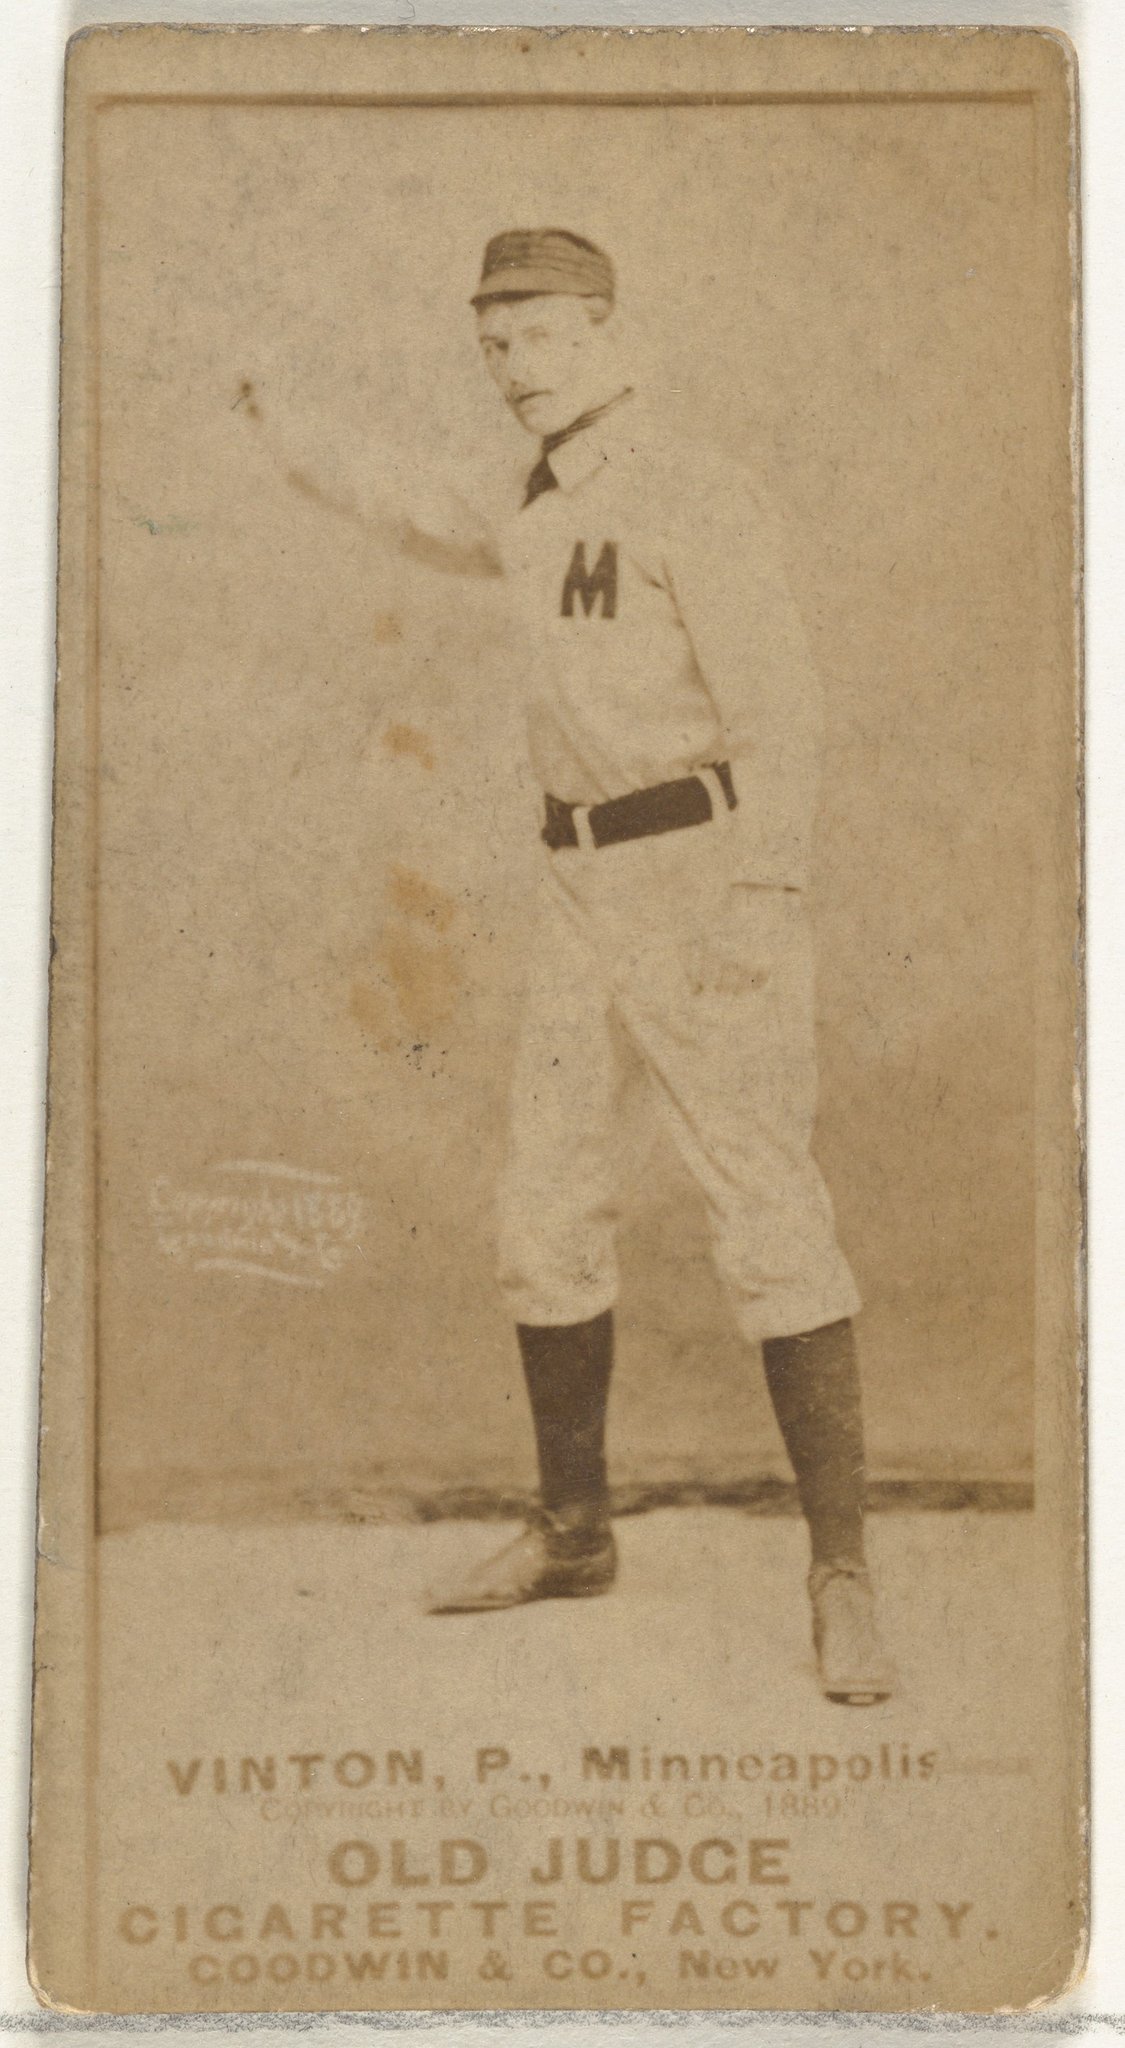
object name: baseball card, photograph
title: William Miller "Bill" Vinton, Pitcher, Minneapolis, from the Old Judge series (N172) for Old Judge Cigarettes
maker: goodwin & company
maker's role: publisher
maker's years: 1850-1950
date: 1889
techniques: albumen silver print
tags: men,portraits,baseball,athletes